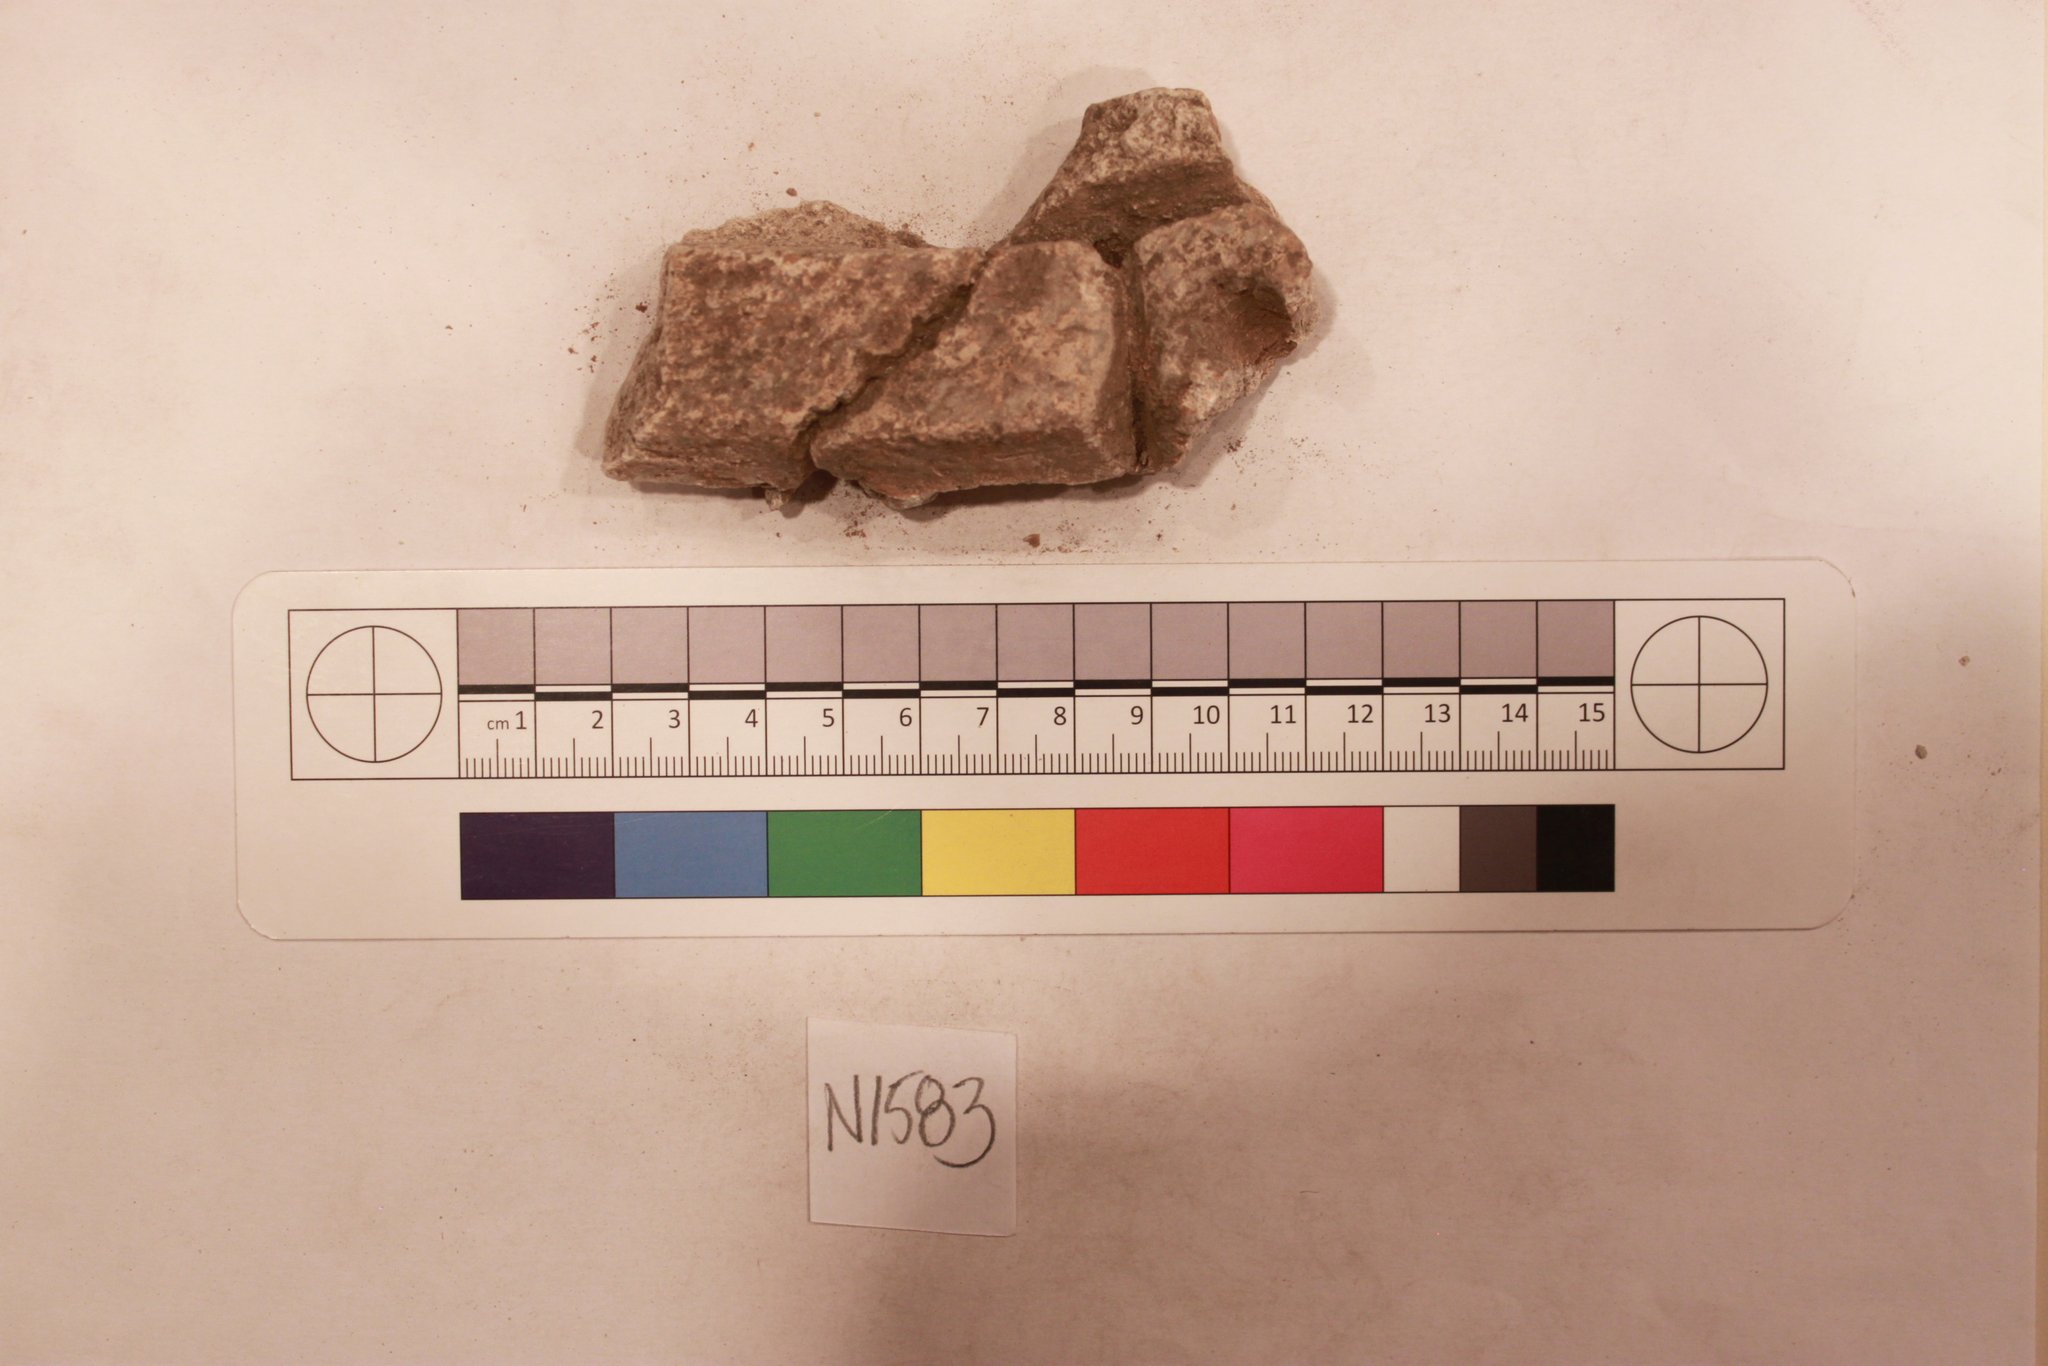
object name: fragment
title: Stucco Fragment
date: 701-1200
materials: plaster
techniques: carving, painting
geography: iran